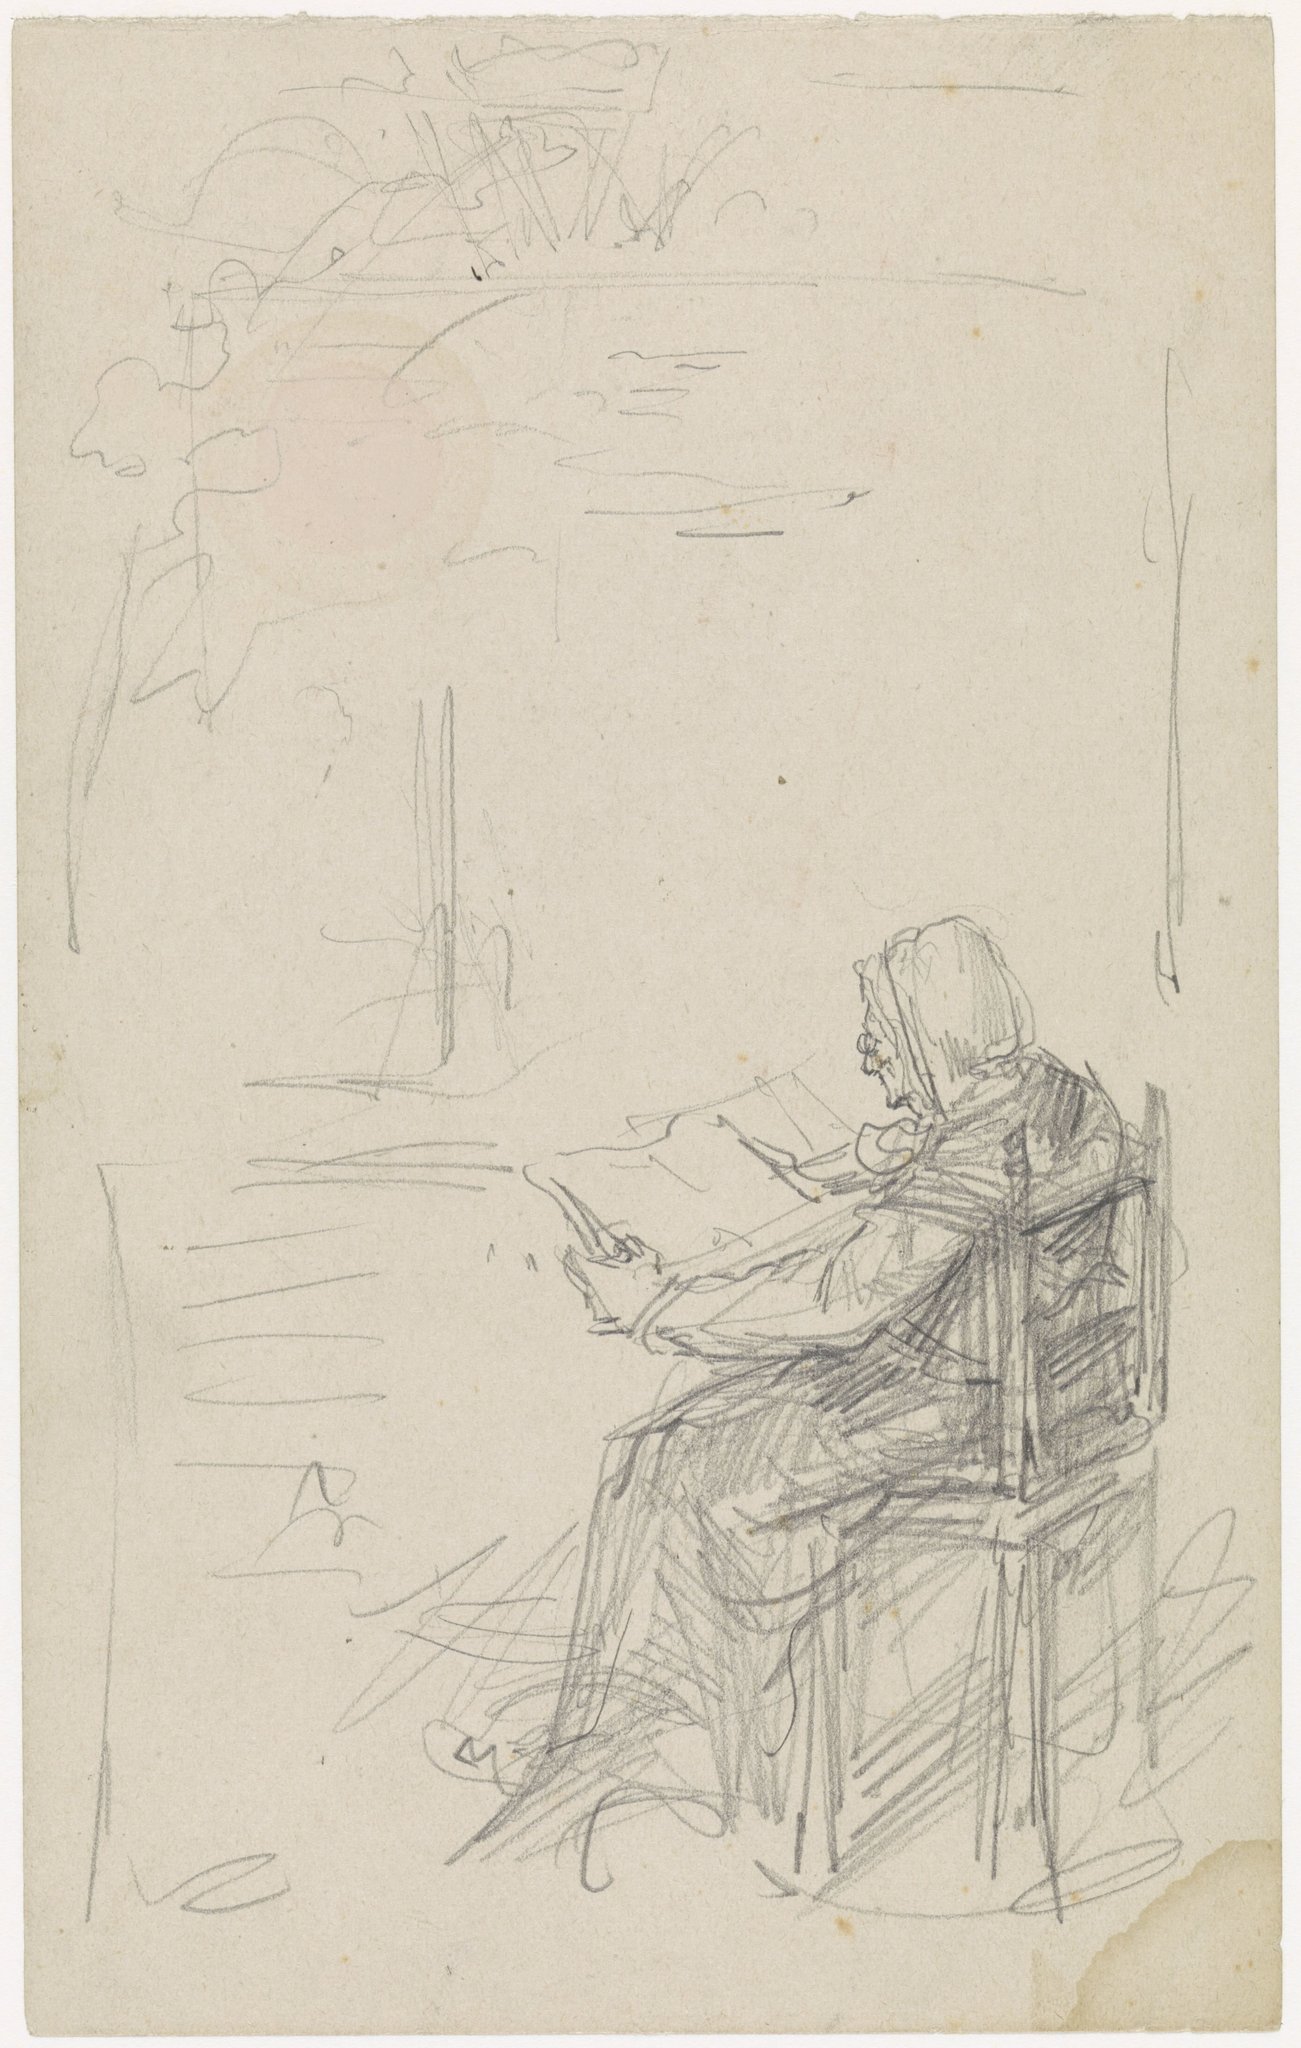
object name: drawing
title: Zittende lezende oude vrouw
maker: antoon derkinderen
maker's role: draughtsman, painter, print maker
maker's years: 1859-1925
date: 1869-1925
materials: paper, pencil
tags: reading